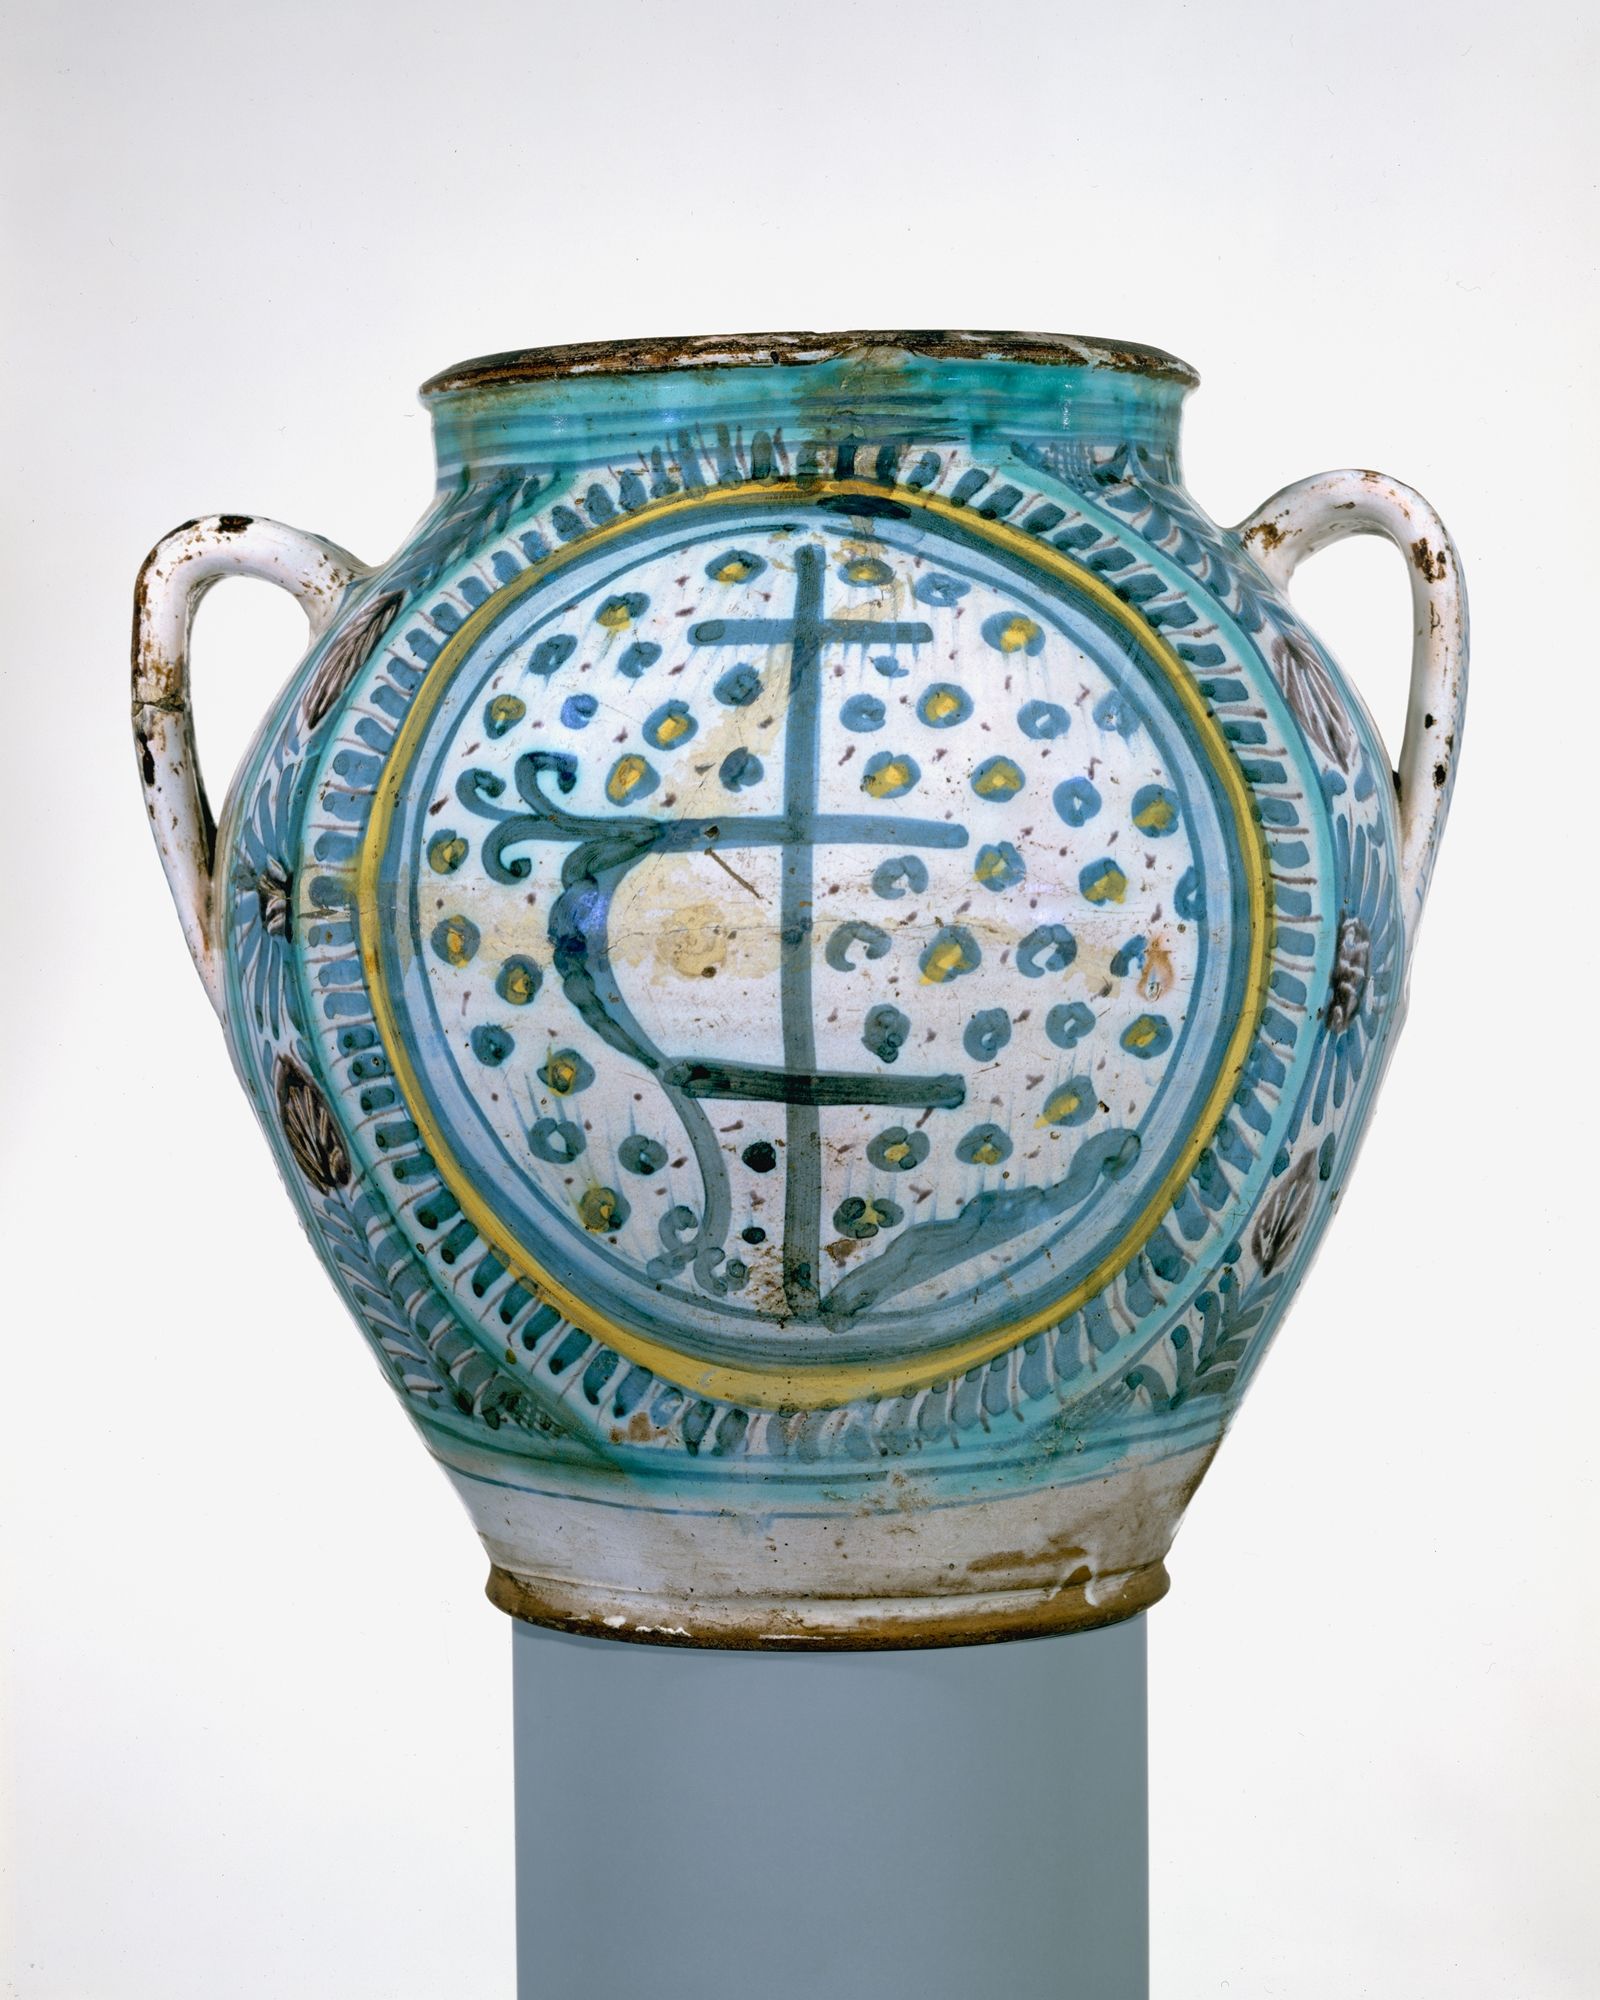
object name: apothecary jar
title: Apothecary jar (orciuolo)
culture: italian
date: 1451-1500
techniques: maiolica, glazing